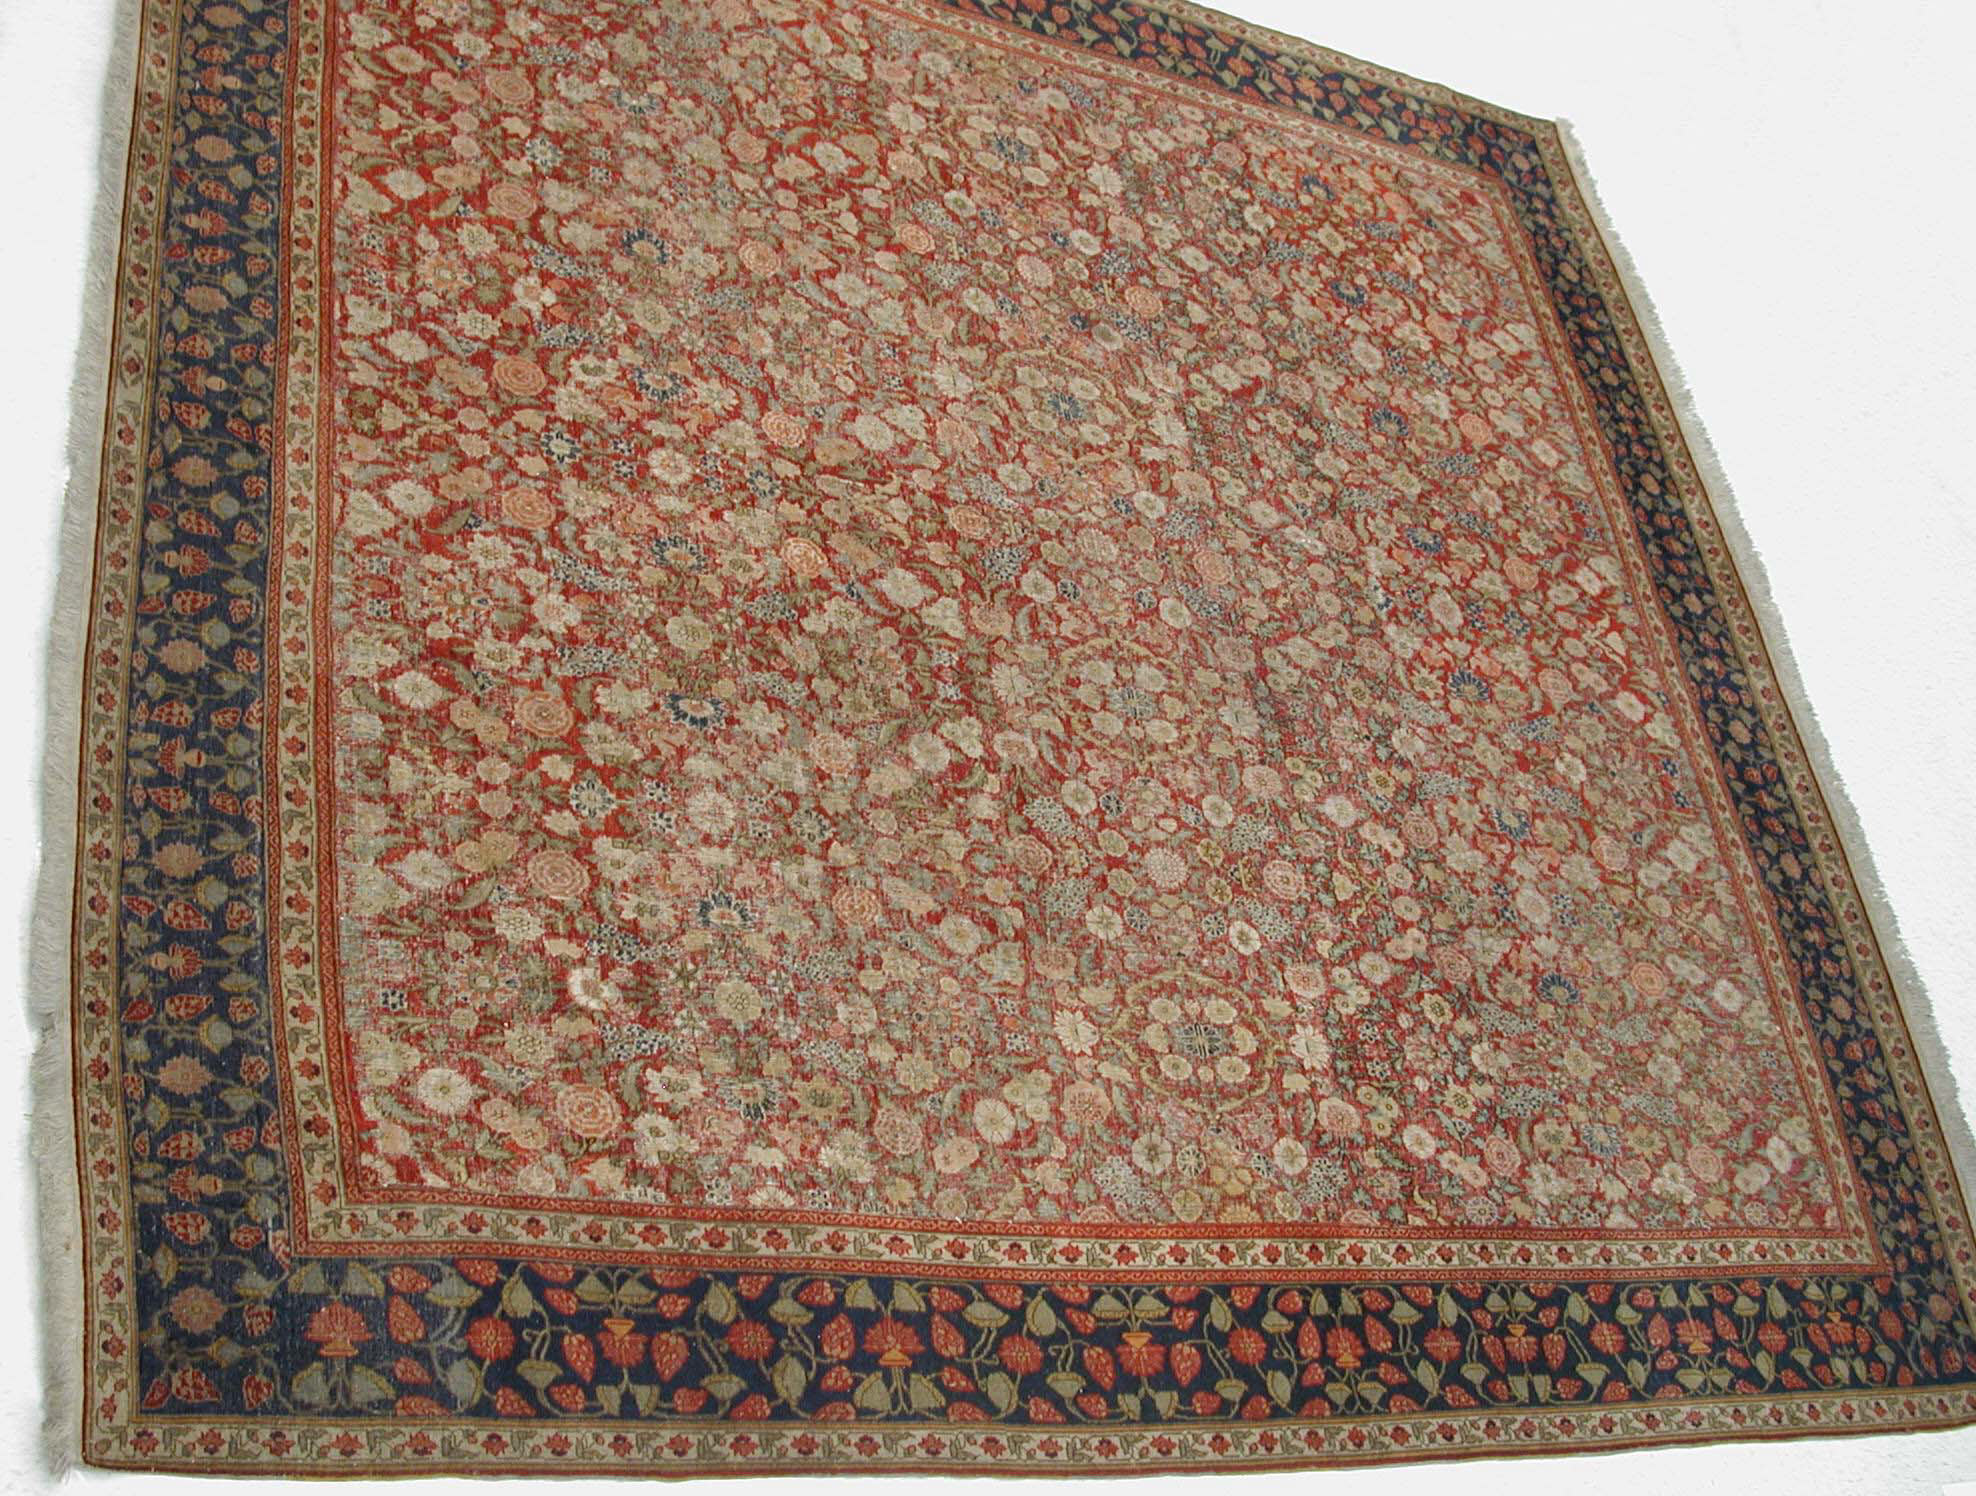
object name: carpet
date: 1767-1833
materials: wool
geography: india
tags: flowers